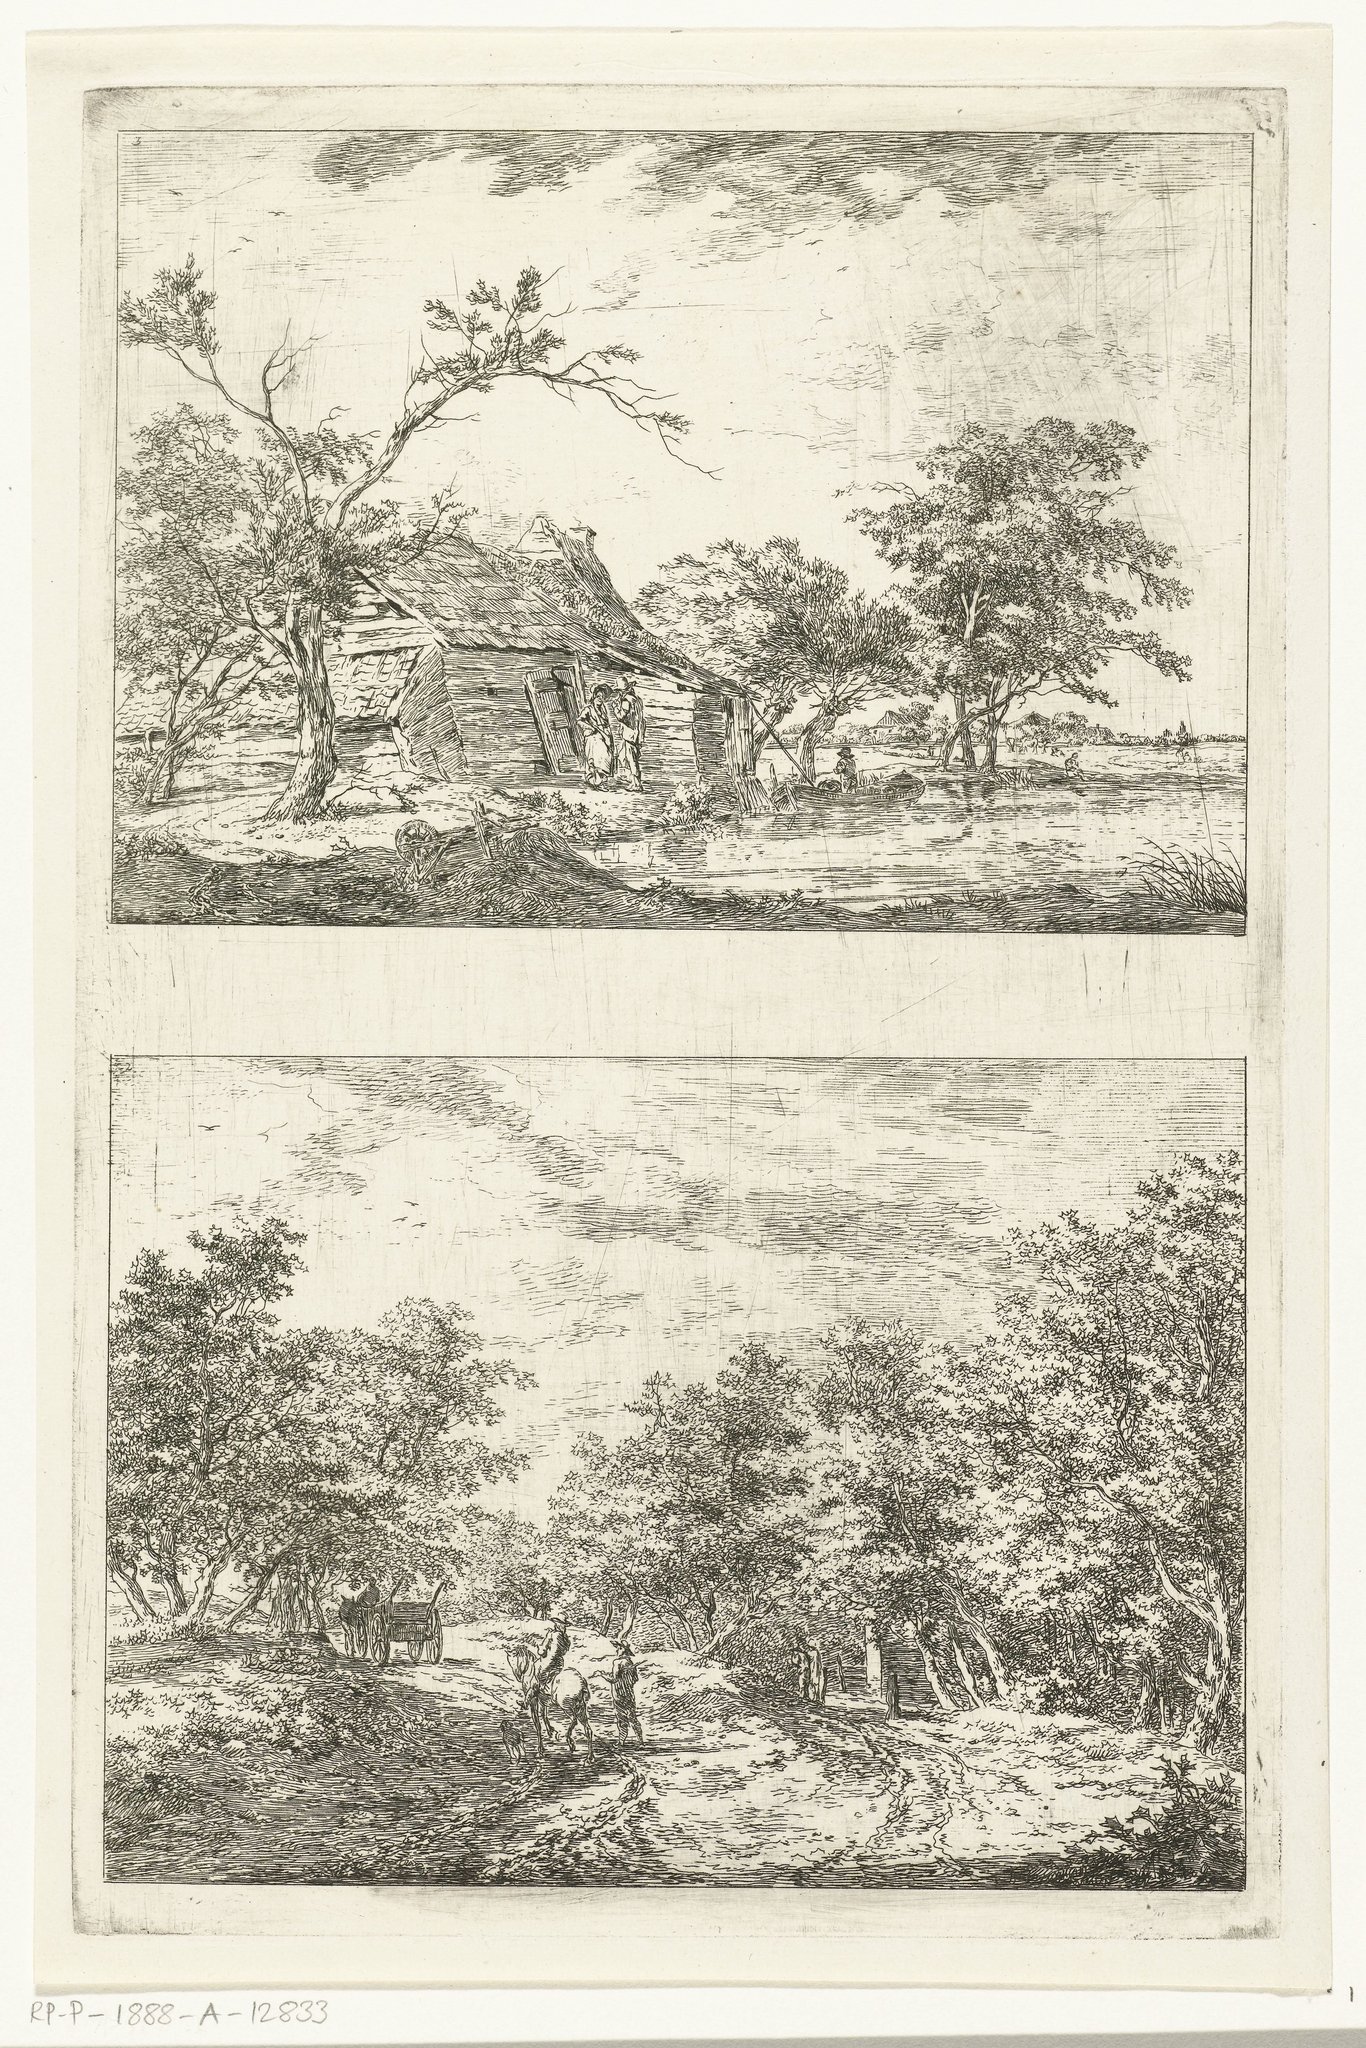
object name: print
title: Twee landschappen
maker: hermanus van brussel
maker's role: draughtsman, print maker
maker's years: 1763-1815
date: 1800-1815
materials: paper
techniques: etching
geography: netherlands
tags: landscapes in the temperate zone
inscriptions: collector's mark: Lugt 2228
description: Twee voorstellingen gedrukt van een plaat. Boven een pratend stel bij een boerderij, onder een pad door het bos met een wagen, ruiter en wandelaar met hond.